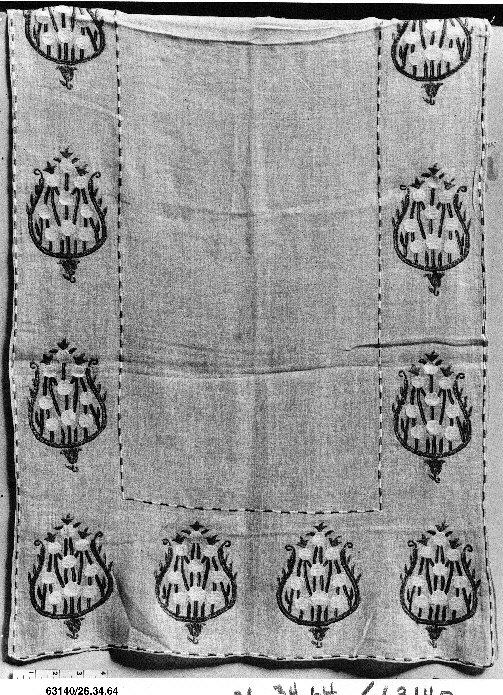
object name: towel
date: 1701-1800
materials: cotton, metal thread, silk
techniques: embroidery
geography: turkey